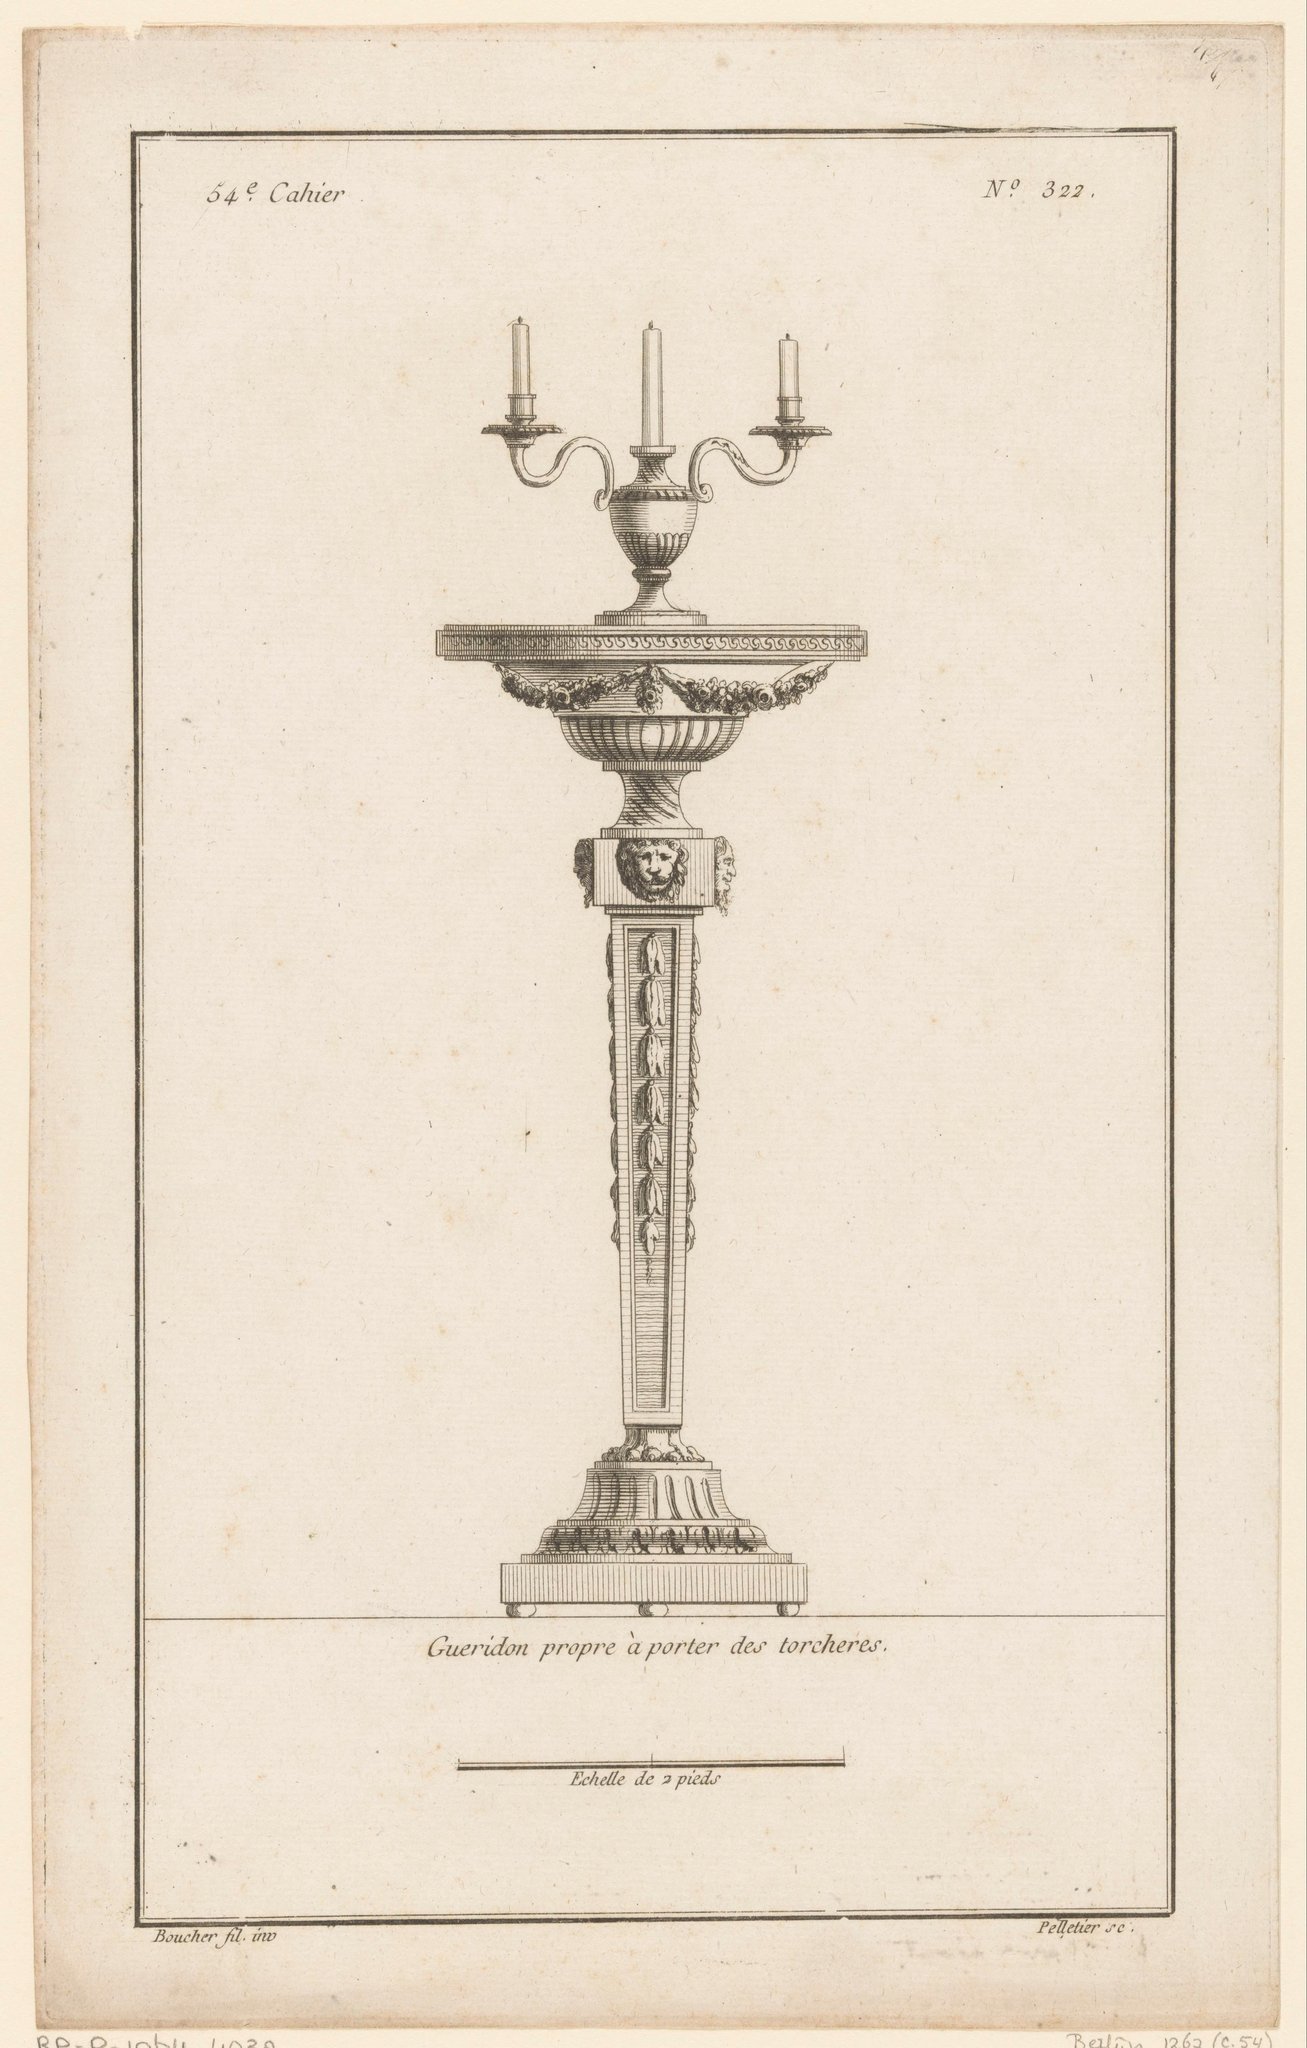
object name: ornament print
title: 54e Cahier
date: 1772-1779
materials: paper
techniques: engraving, etching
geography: paris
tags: lion's head ~ ornament, chandelier, candelabrum, table, ornament ~ festoon, garland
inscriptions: collector's mark: Lugt 2760, collector's mark: Lugt 2228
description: Een gueridon met driearmige kandelaar, guirlandes en een leeuwenkop. Prentnummer 322.